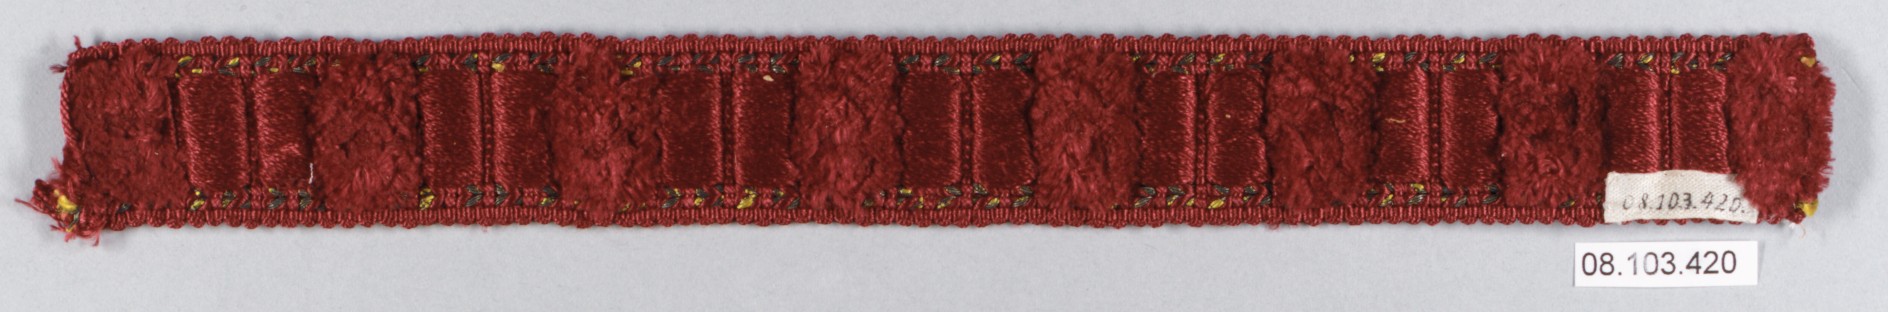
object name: galloon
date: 1601-1700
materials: metal thread